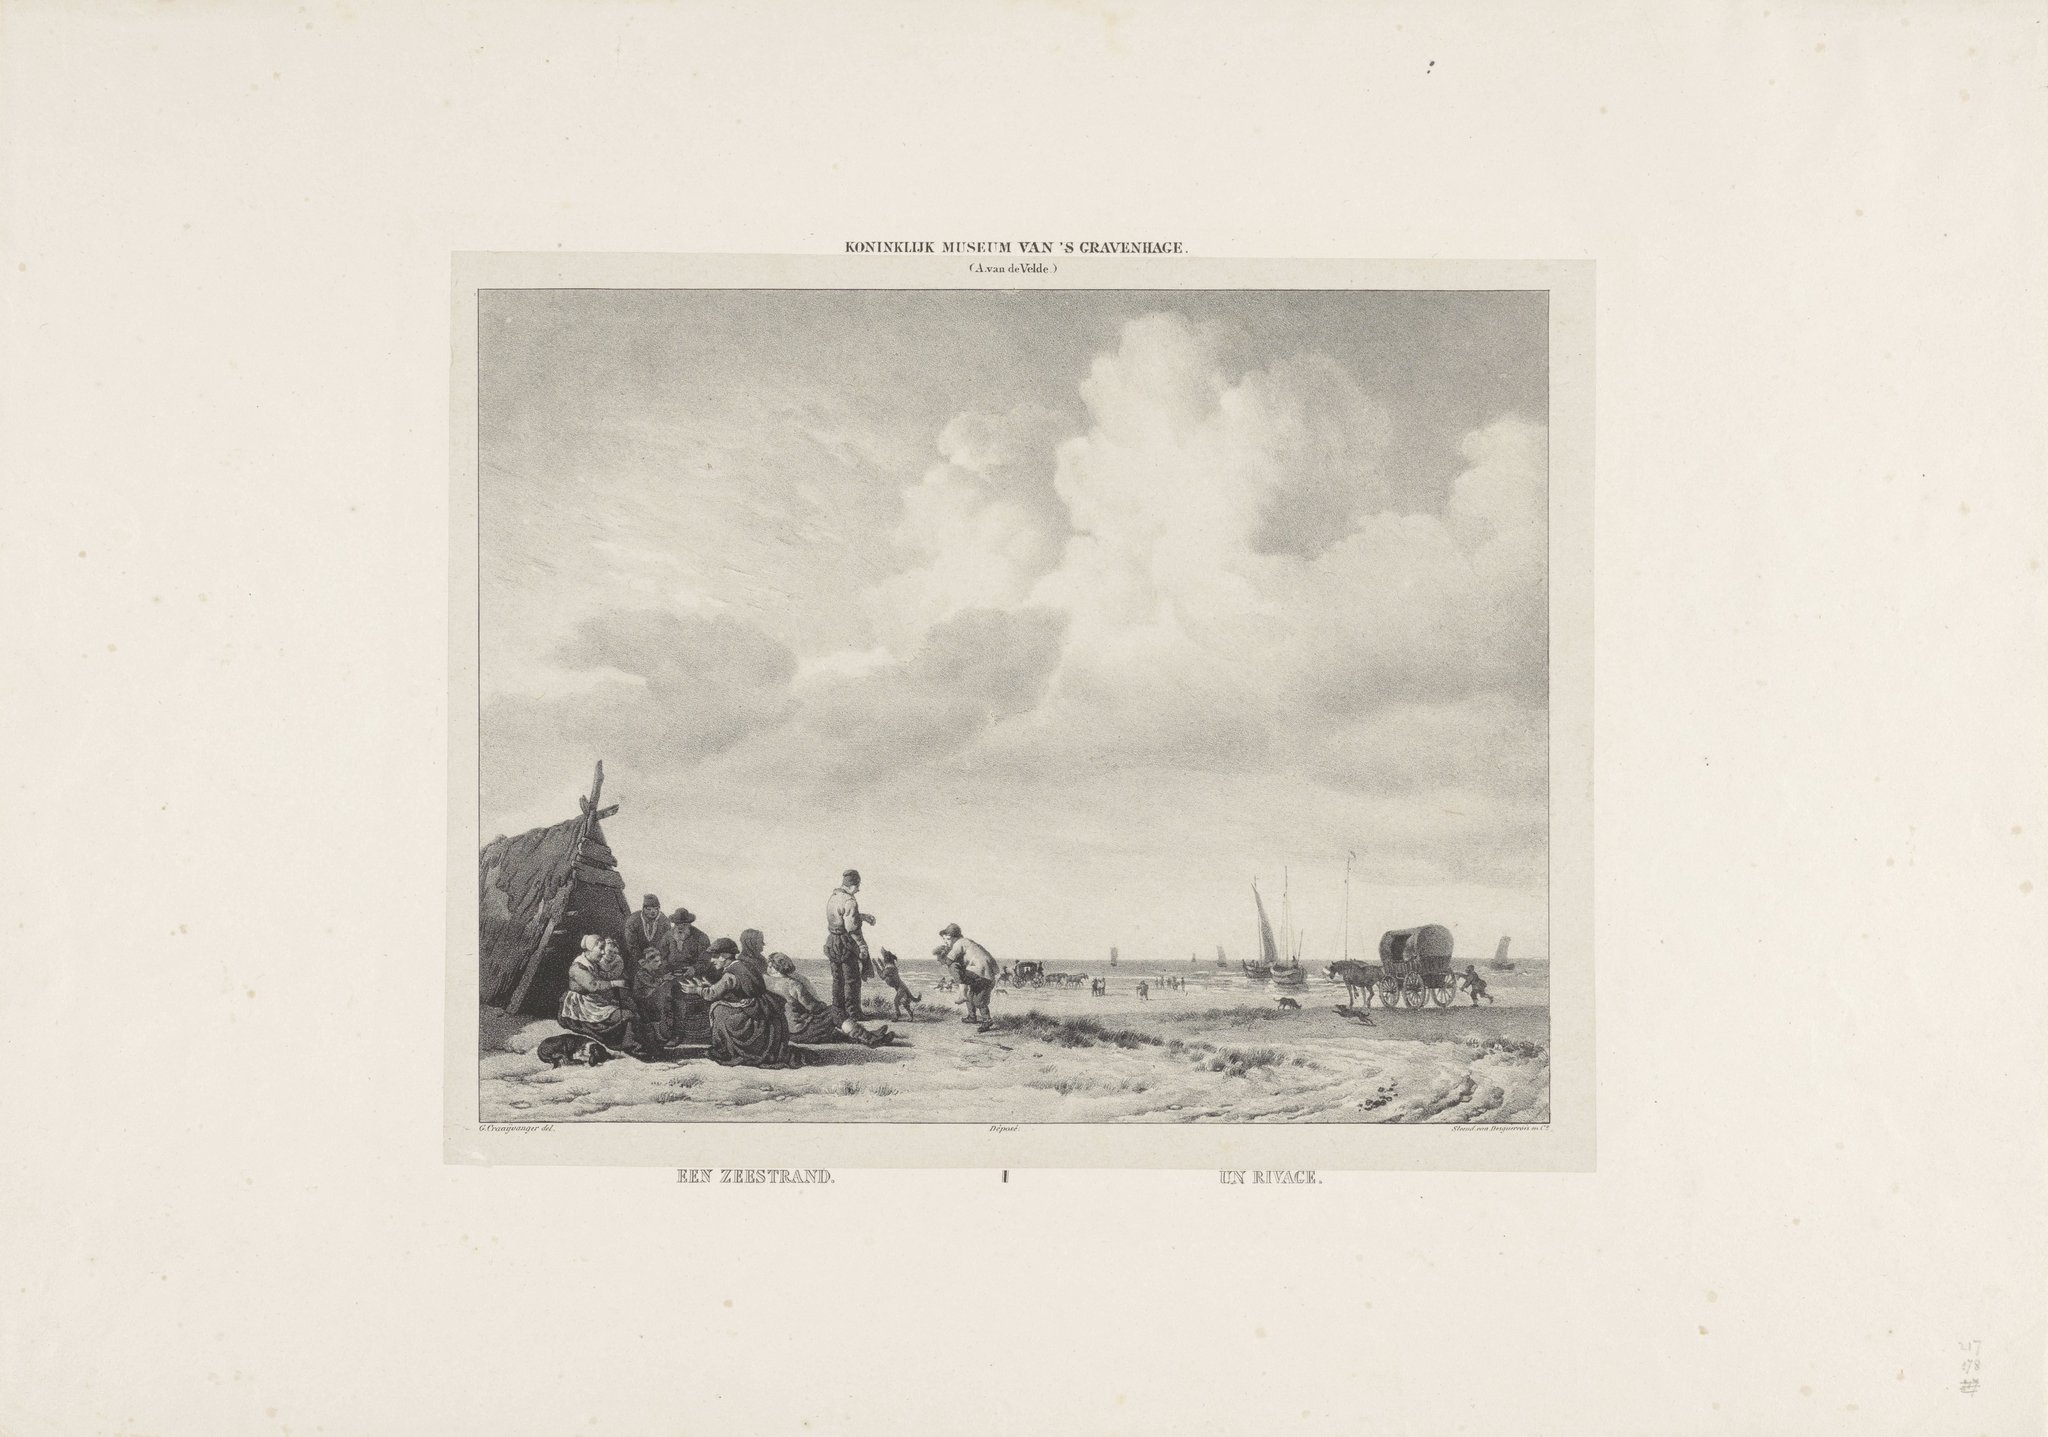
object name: book illustration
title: Een zeestrand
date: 1833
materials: paper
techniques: lithograph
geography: netherlands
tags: sailing-ship, sailing-boat, beach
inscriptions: collector's mark: Lugt 2228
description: Links op het strand, bij een houten hut, heeft een groepje vissers zich verzameld. Zij delen een maaltijd. Rechts rijdt een huifkar met een figuur en twee honden. Over het strand rijdt een rijtuig voortgetrokken door vier paarden. Op het water liggen verschillende bomschuiten. De prent werd gemaakt naar een schilderij door Adriaen van de Velde in het Mauritshuis in Den Haag.